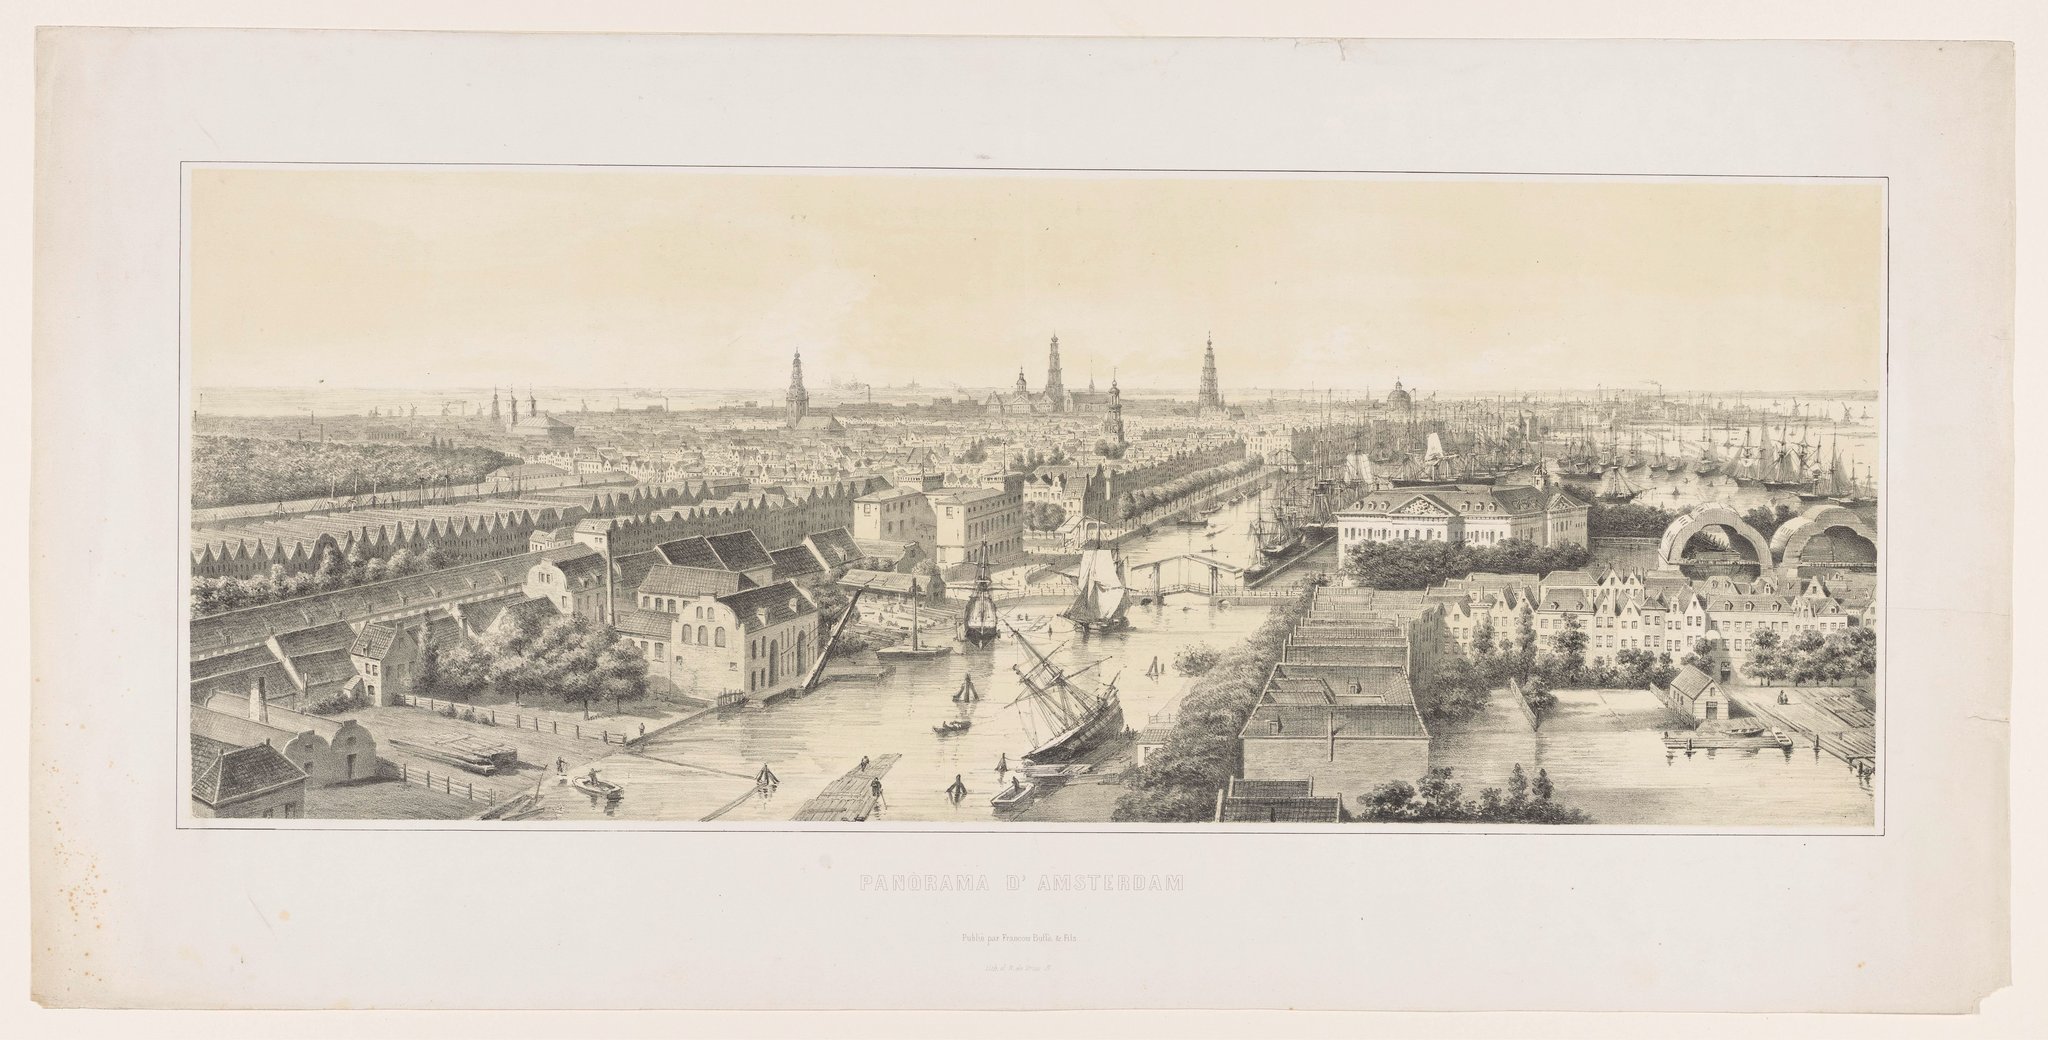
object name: print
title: Panorama van Amsterdam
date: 1847-1891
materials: paper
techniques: lithograph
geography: amsterdam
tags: city-view, and landscape with man-made constructions, prospect of city, town panorama, silhouette of city, amsterdam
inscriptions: collector's mark: Lugt 2228